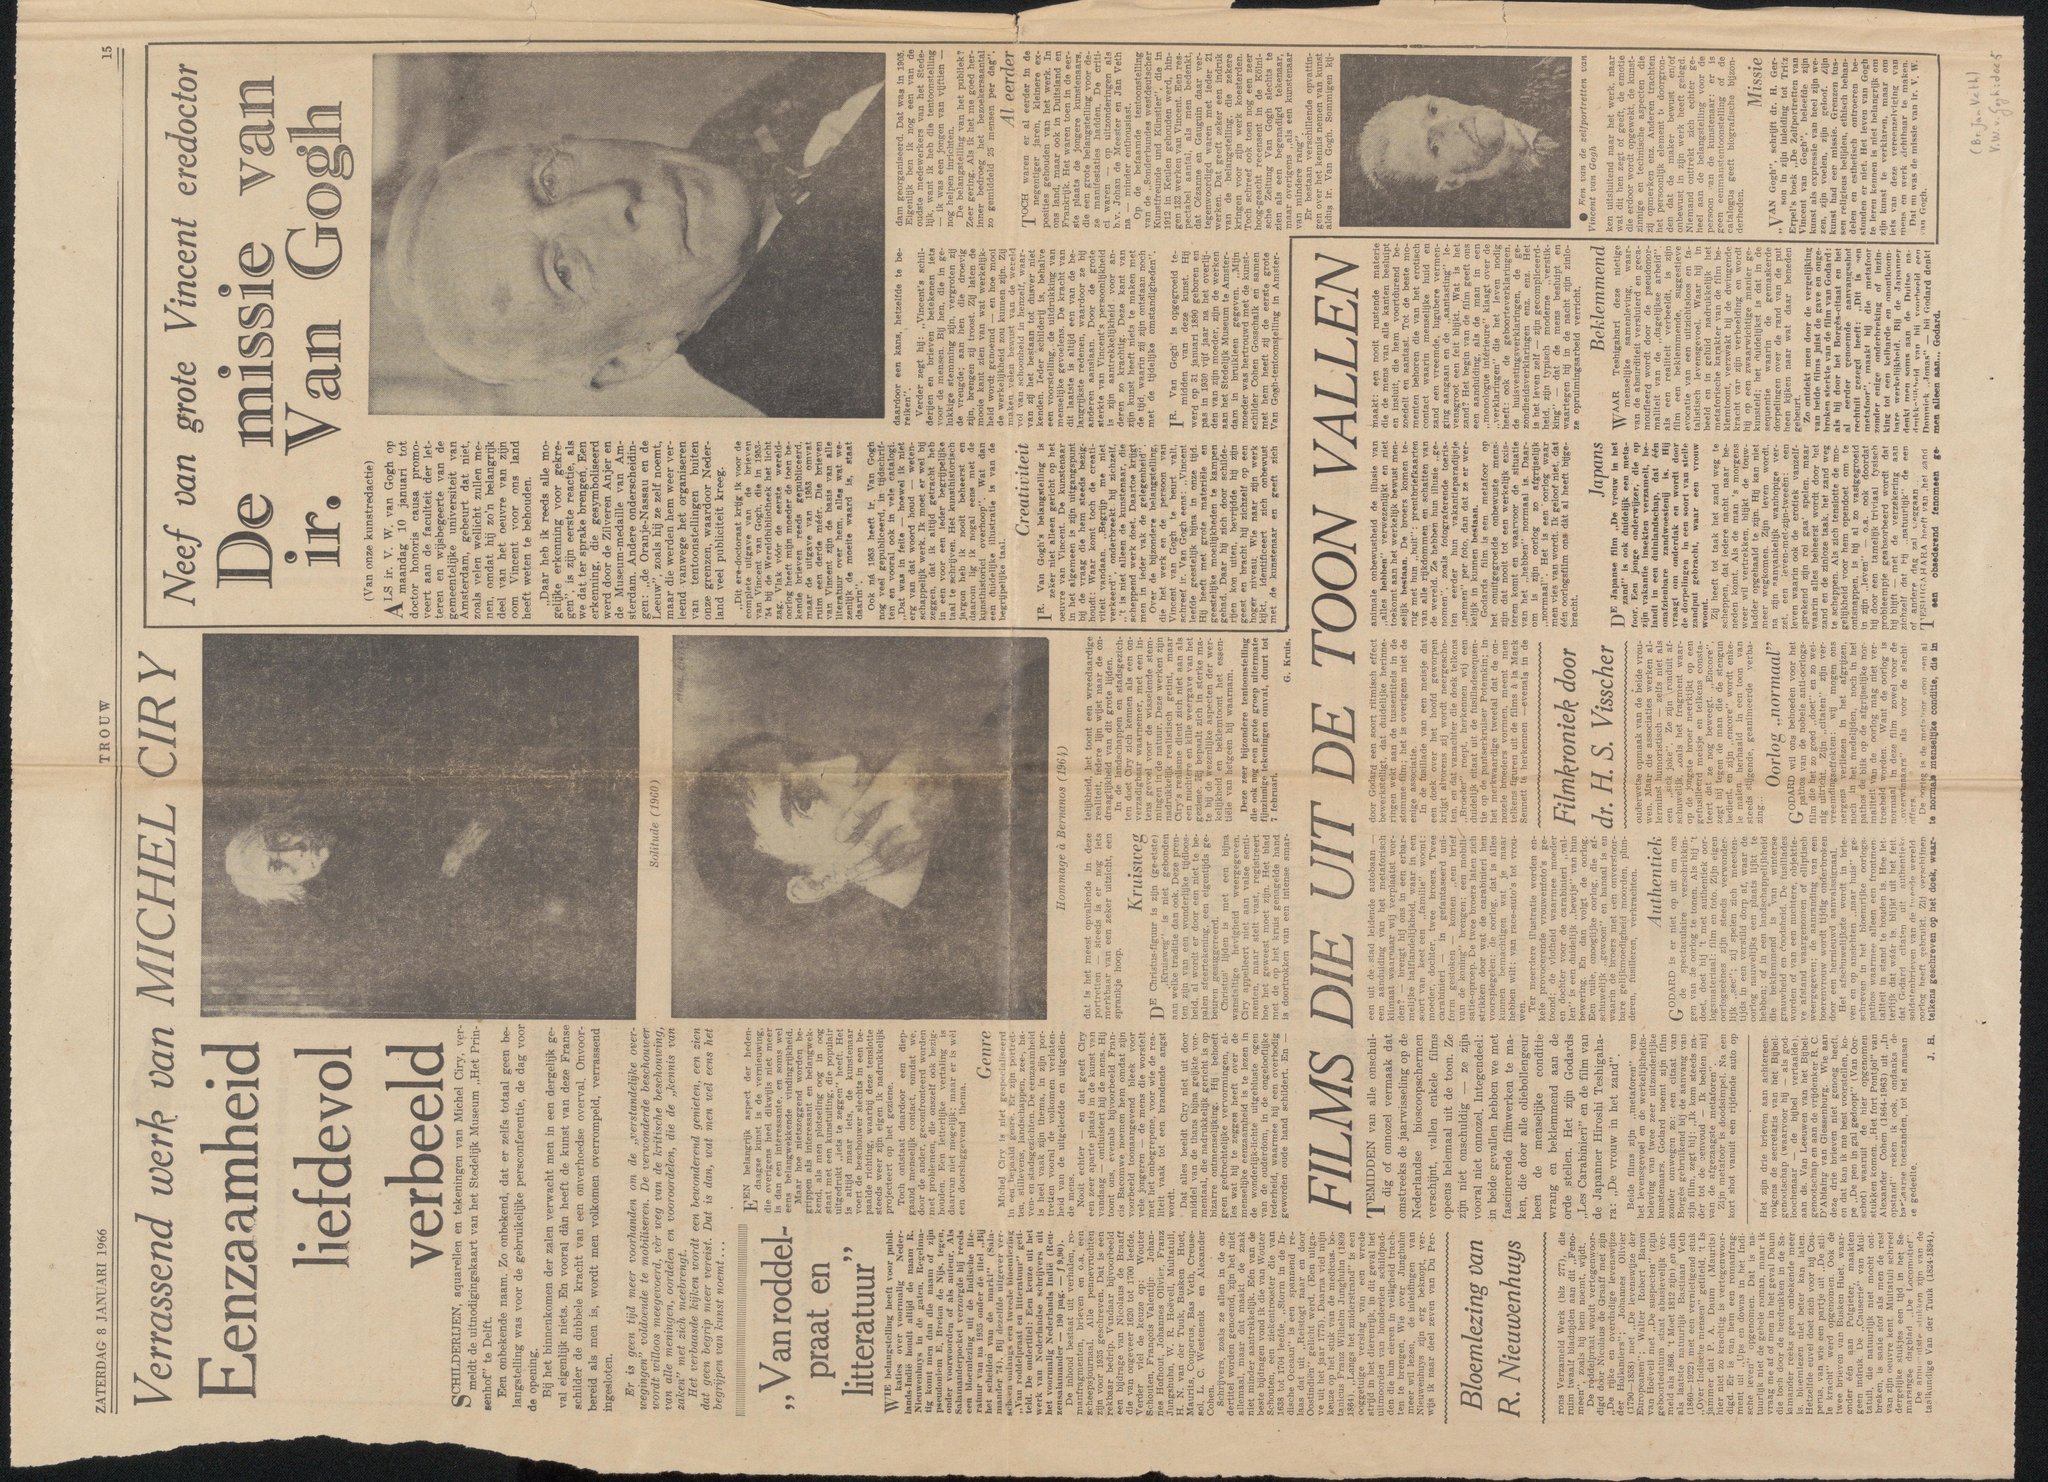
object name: newspaper clipping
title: Krantenknipsel uit archief Jan Veth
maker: Anonymous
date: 1966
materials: paper, ink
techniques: printing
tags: paris, engineer, vincent willem van gogh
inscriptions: collector's mark: ‘RPK’